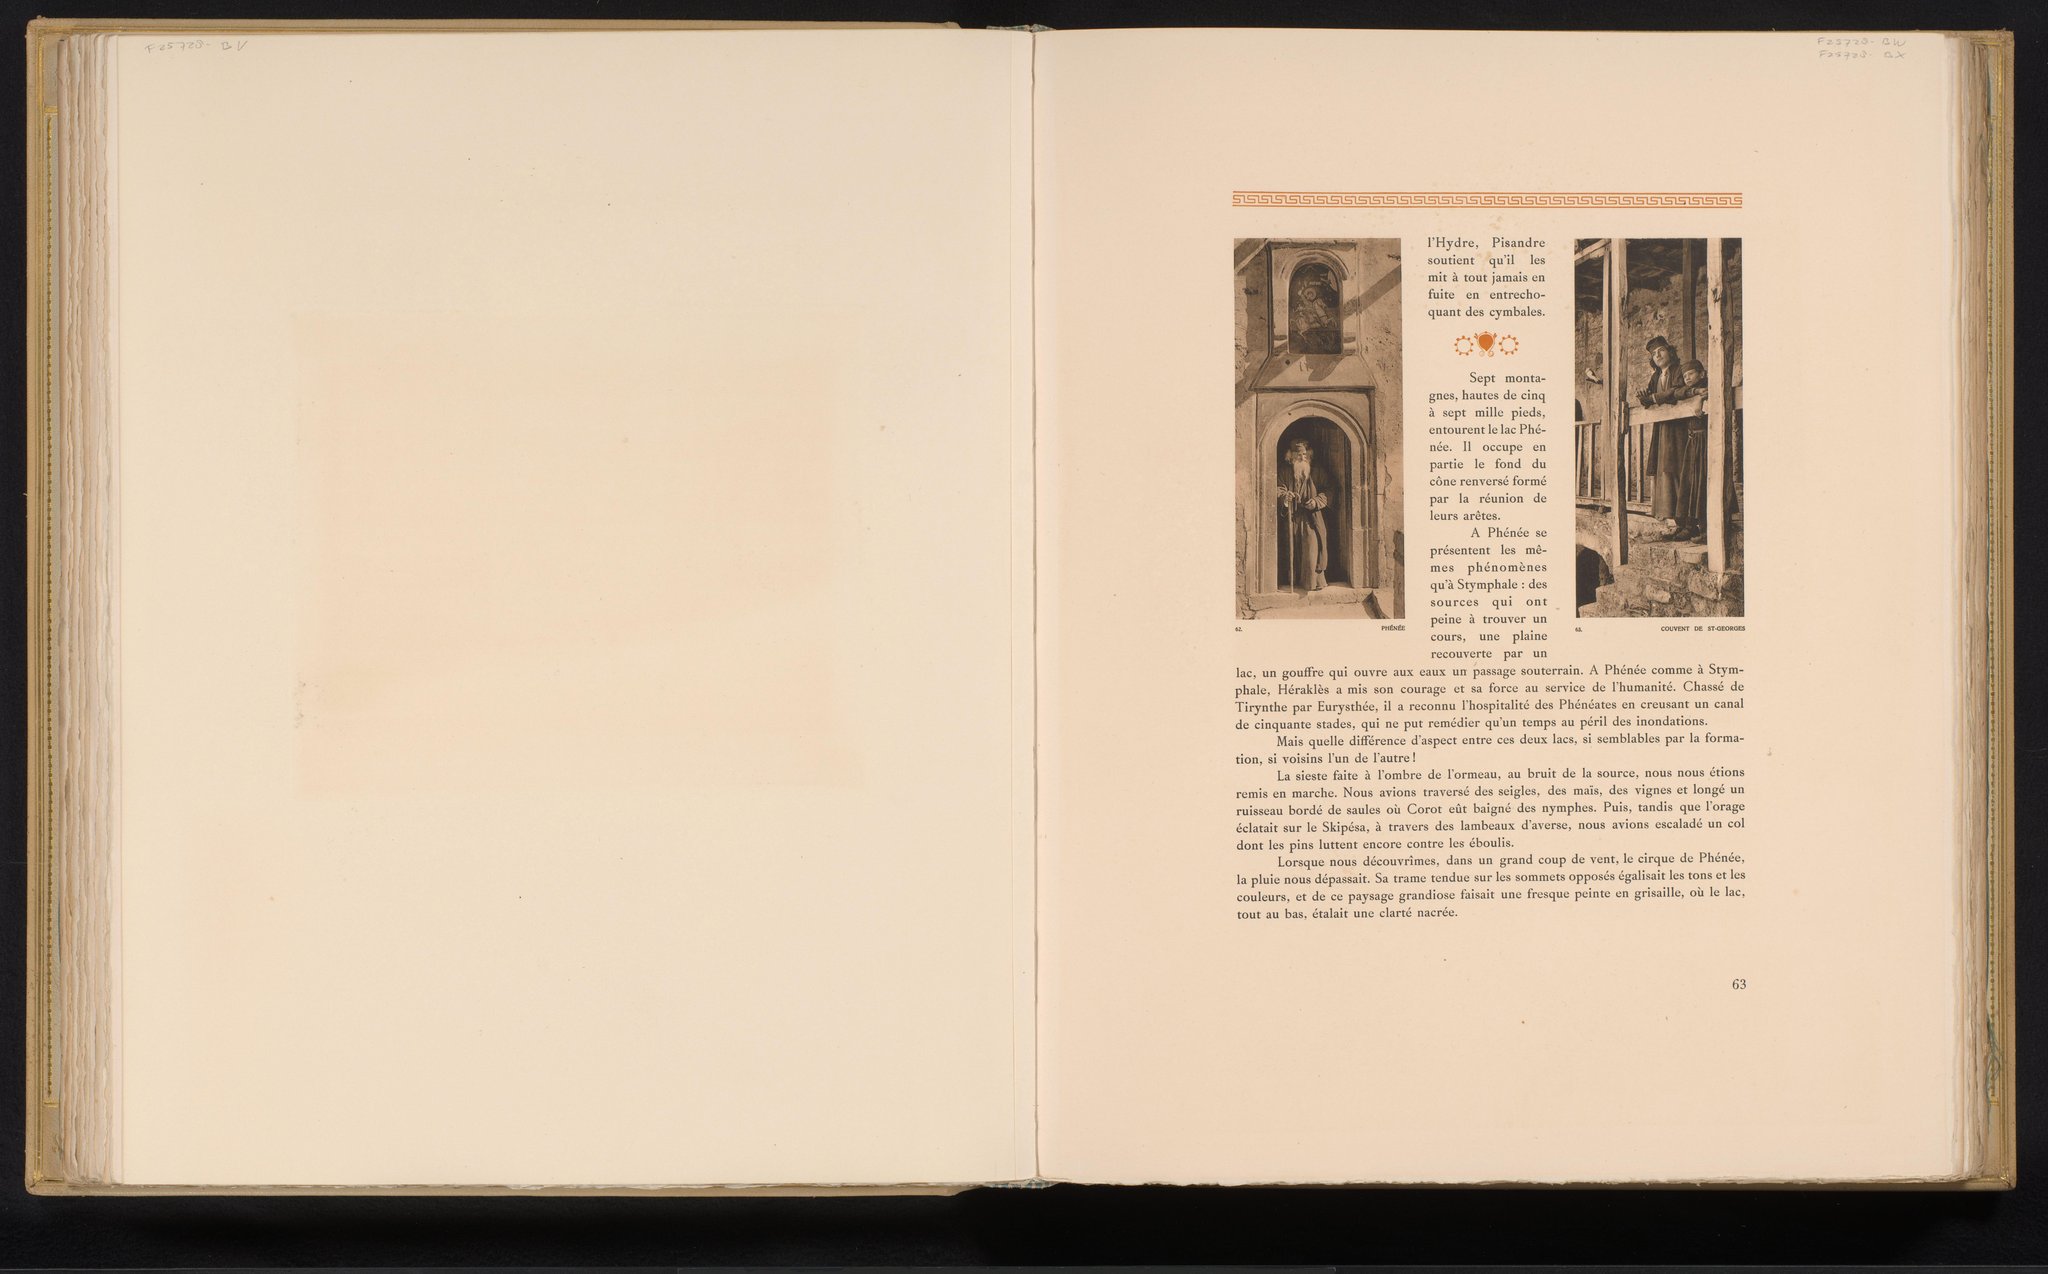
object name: page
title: Couvent de St. Georges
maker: frédéric boissonnas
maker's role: fotograaf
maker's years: 1858-1946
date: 1905-1910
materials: paper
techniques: photograph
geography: berlin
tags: boy (child between toddler and youth)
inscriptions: number: ‘63.’